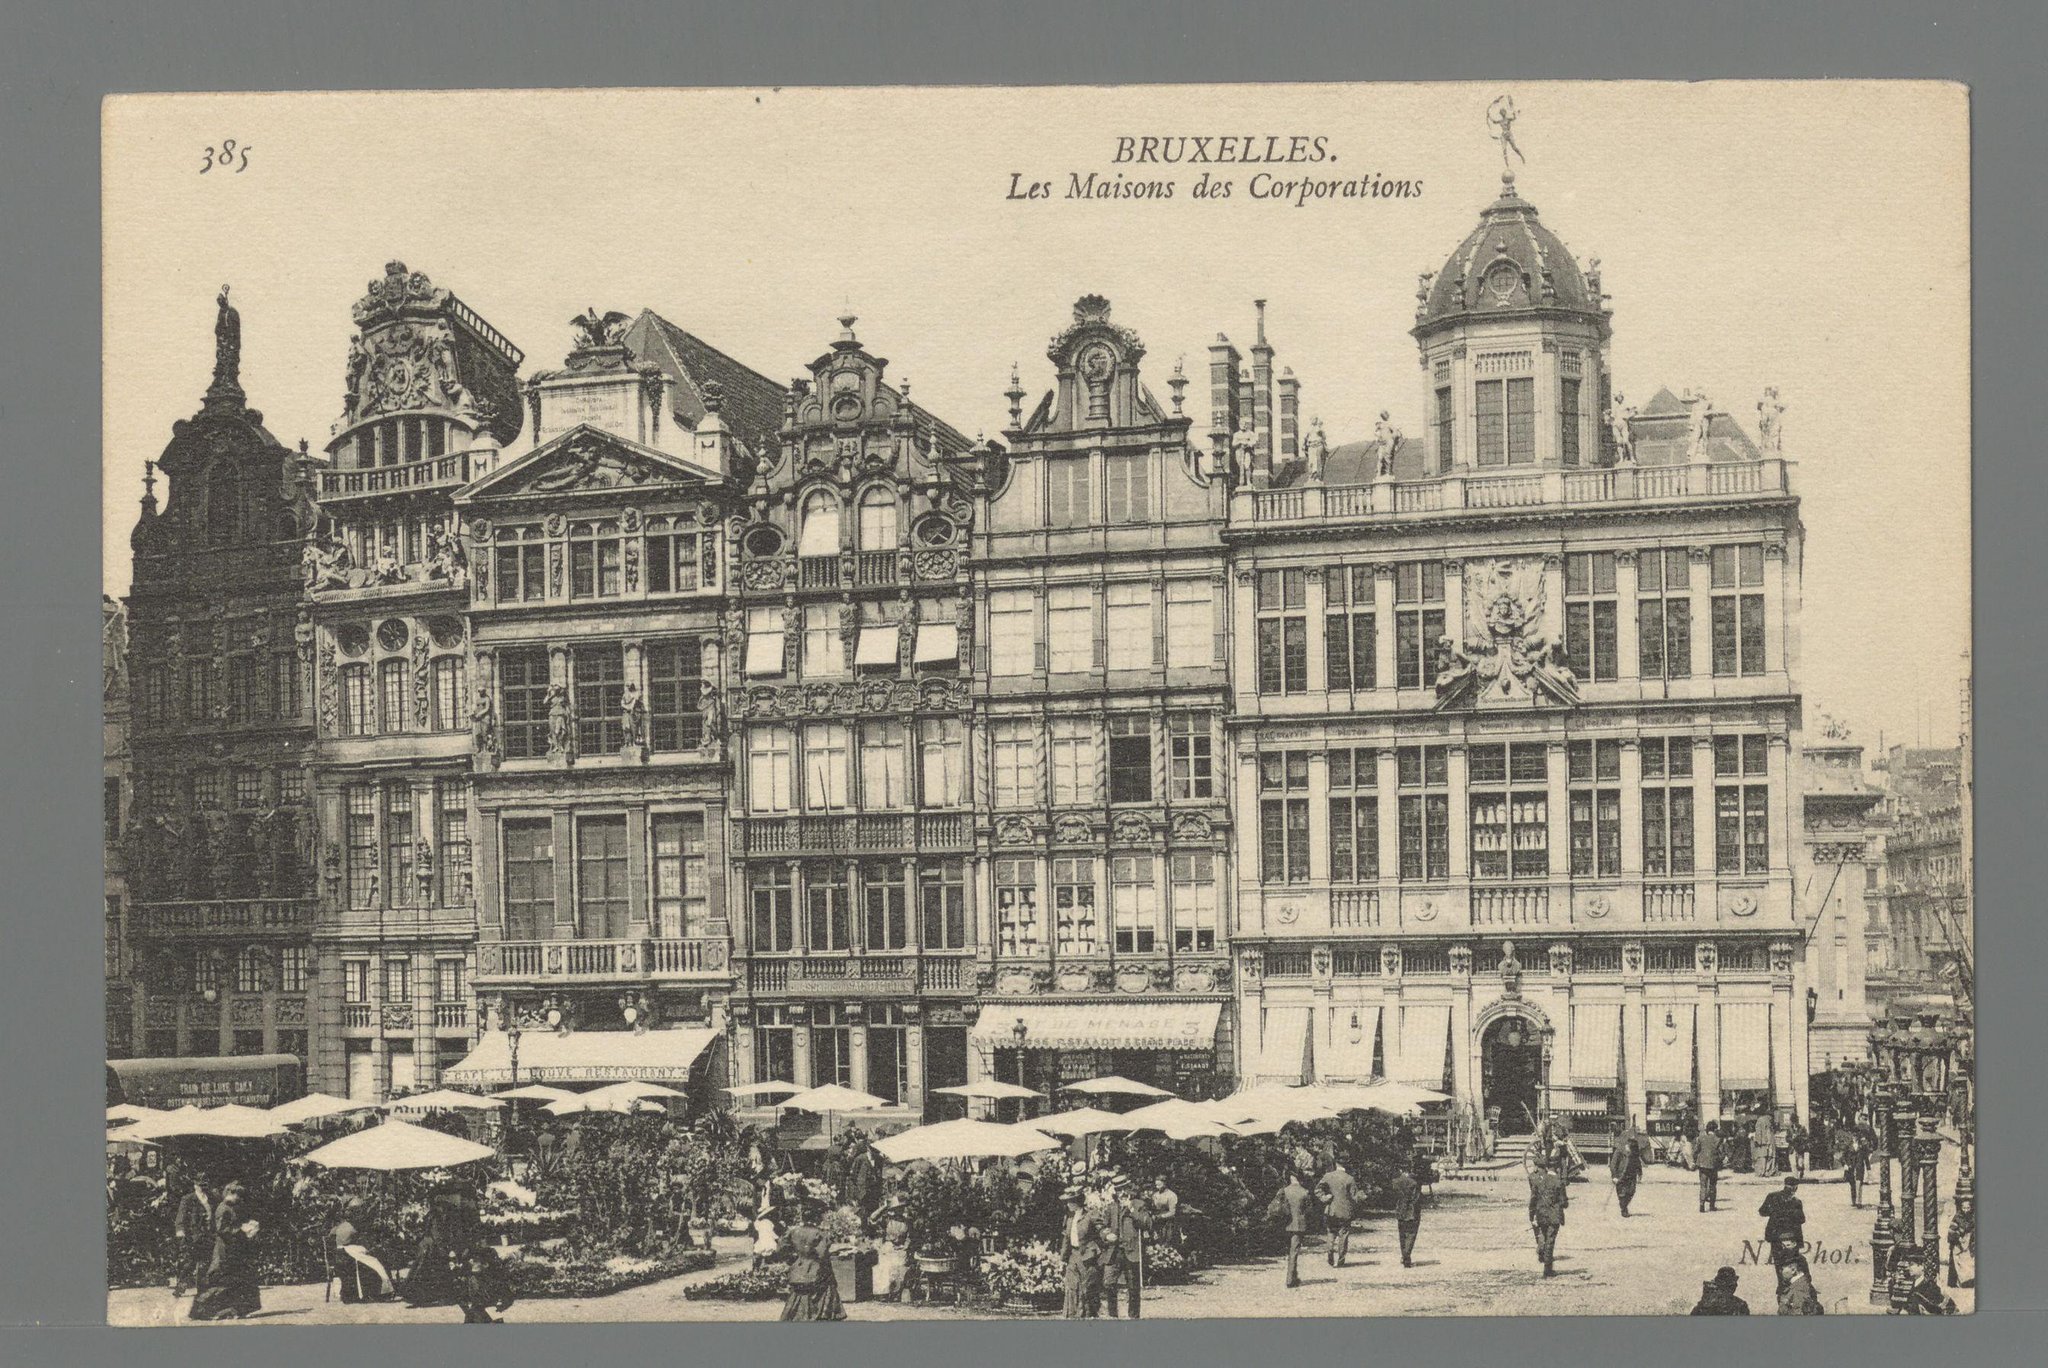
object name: ansichtkaart, prentbriefkaart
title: Bruxelles. Les Maisons des Corporations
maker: Anonymous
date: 1906-1918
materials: cardboard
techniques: photograph, writing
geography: brussels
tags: square, place, circus, etc., market, city-view, and landscape with man-made constructions (+ city(-scape) with figures, staffage)